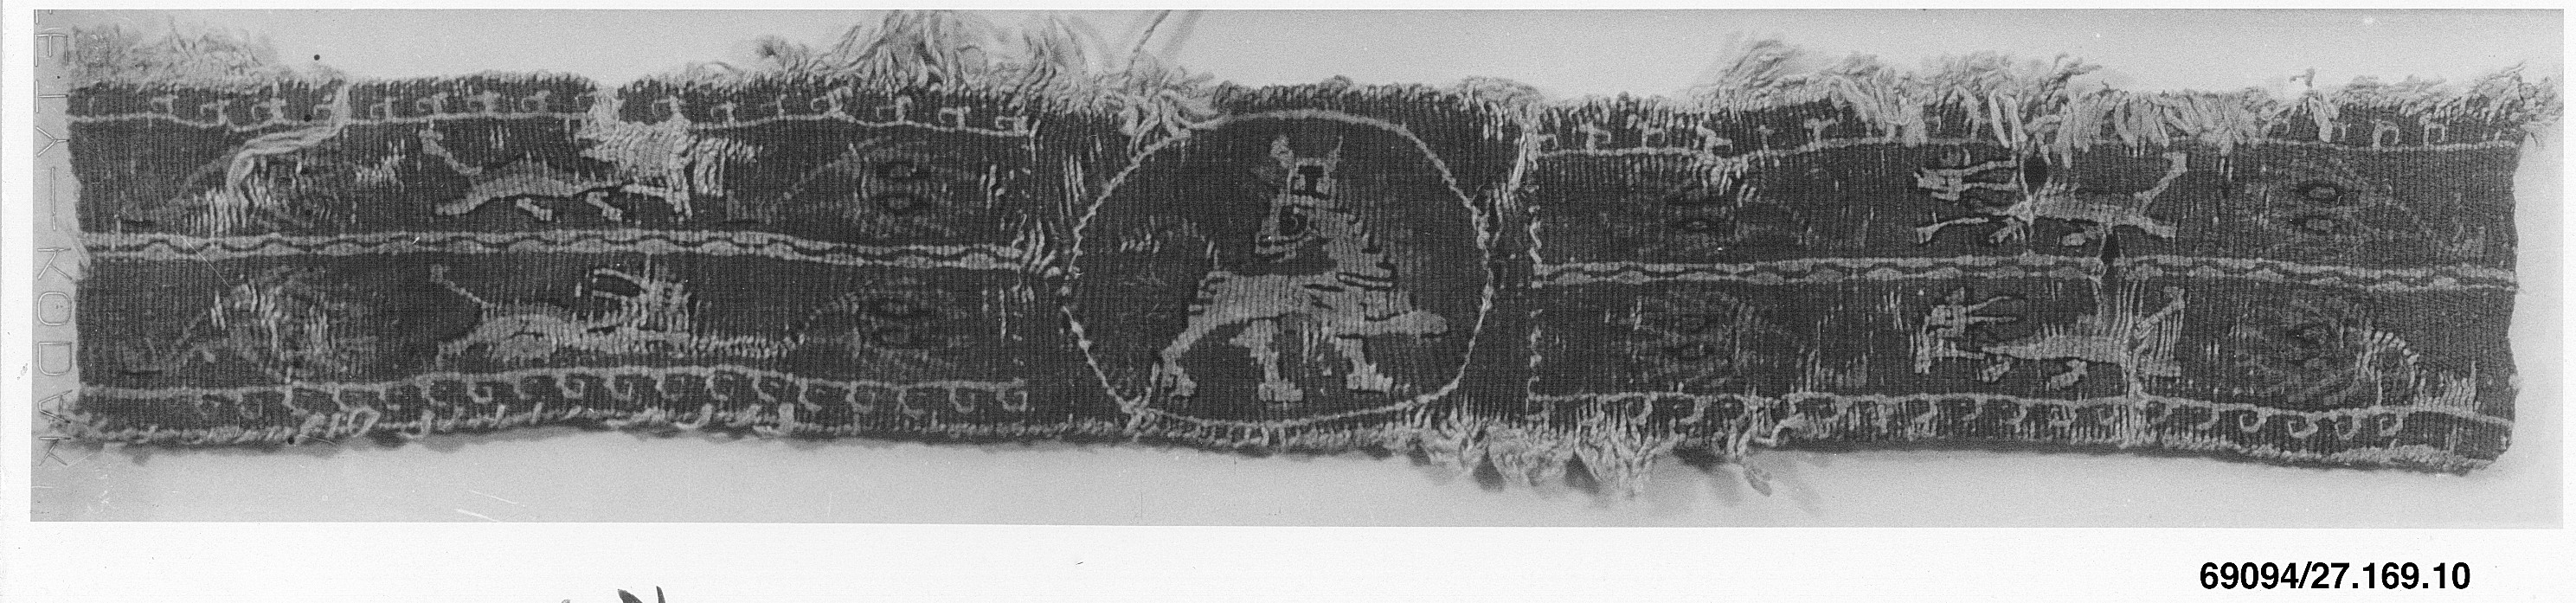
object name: band fragment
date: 501-600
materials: linen, wool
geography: egypt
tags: animals